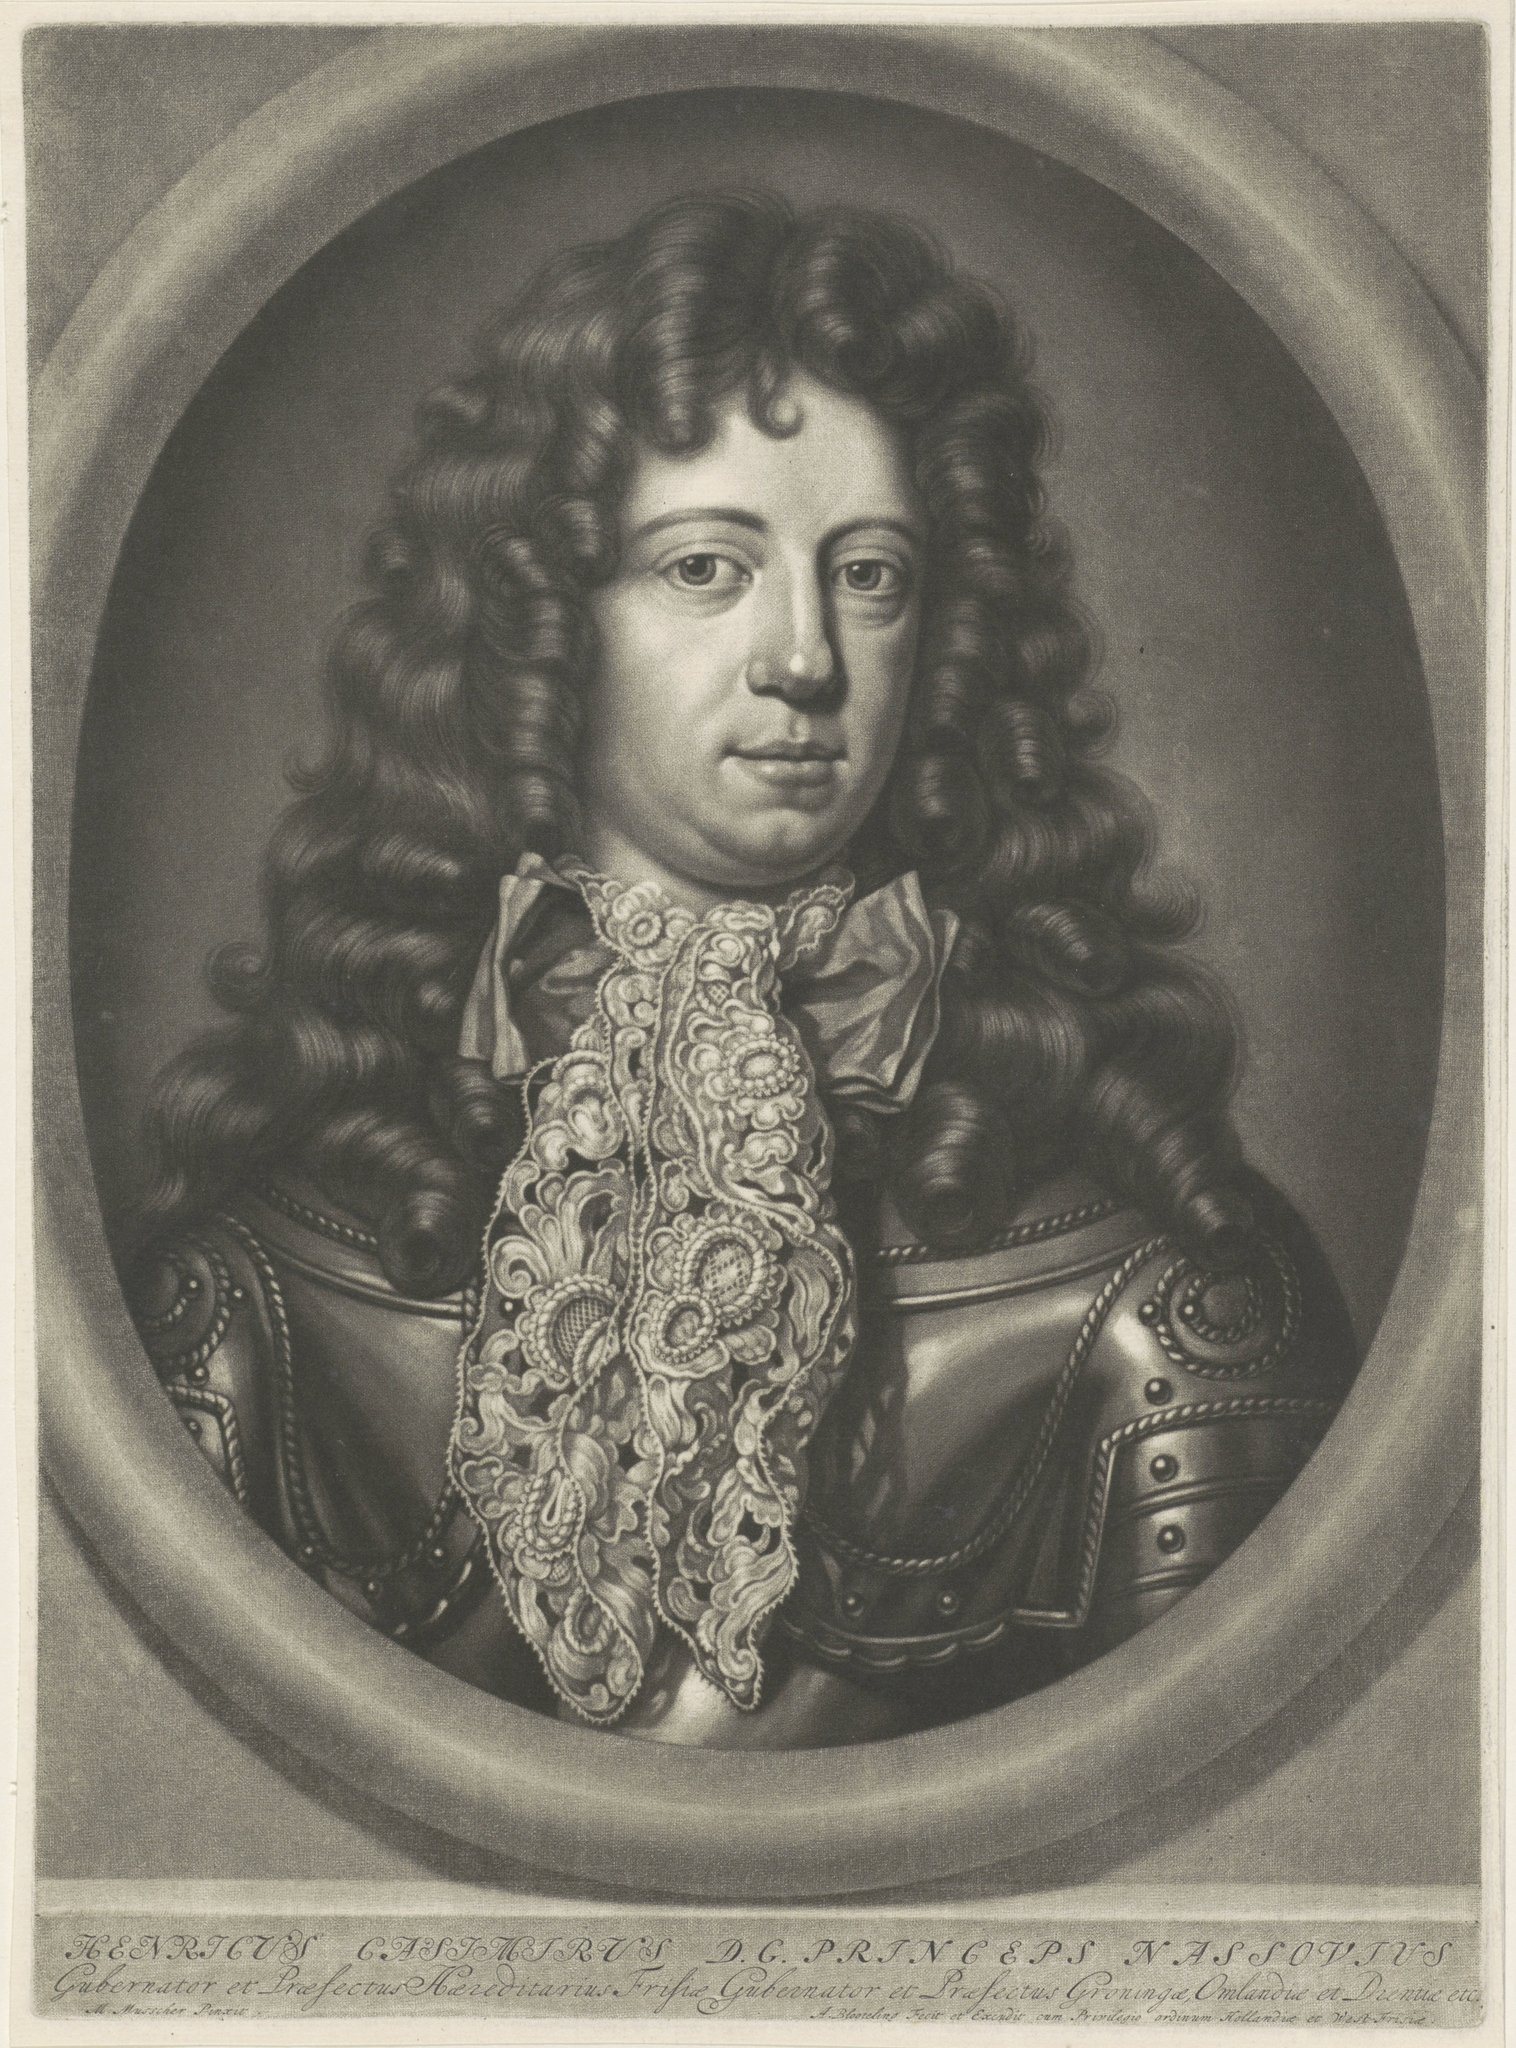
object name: print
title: Portret van Hendrik Casimir II, graaf van Nassau-Dietz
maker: michiel van musscher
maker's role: draughtsman, painter, print maker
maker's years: 1645-1705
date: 1675-1690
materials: paper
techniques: mezzotint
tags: the hague, hendrik casimir ii graaf van nassau-dietz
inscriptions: collector's mark: Lugt 11, collector's mark: Lugt 10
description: De hier vermelde titel verwijst naar de hoogst verkregen titel van de geportretteerde, niet per se naar de titel die de geportretteerde op deze voorstelling draagt.